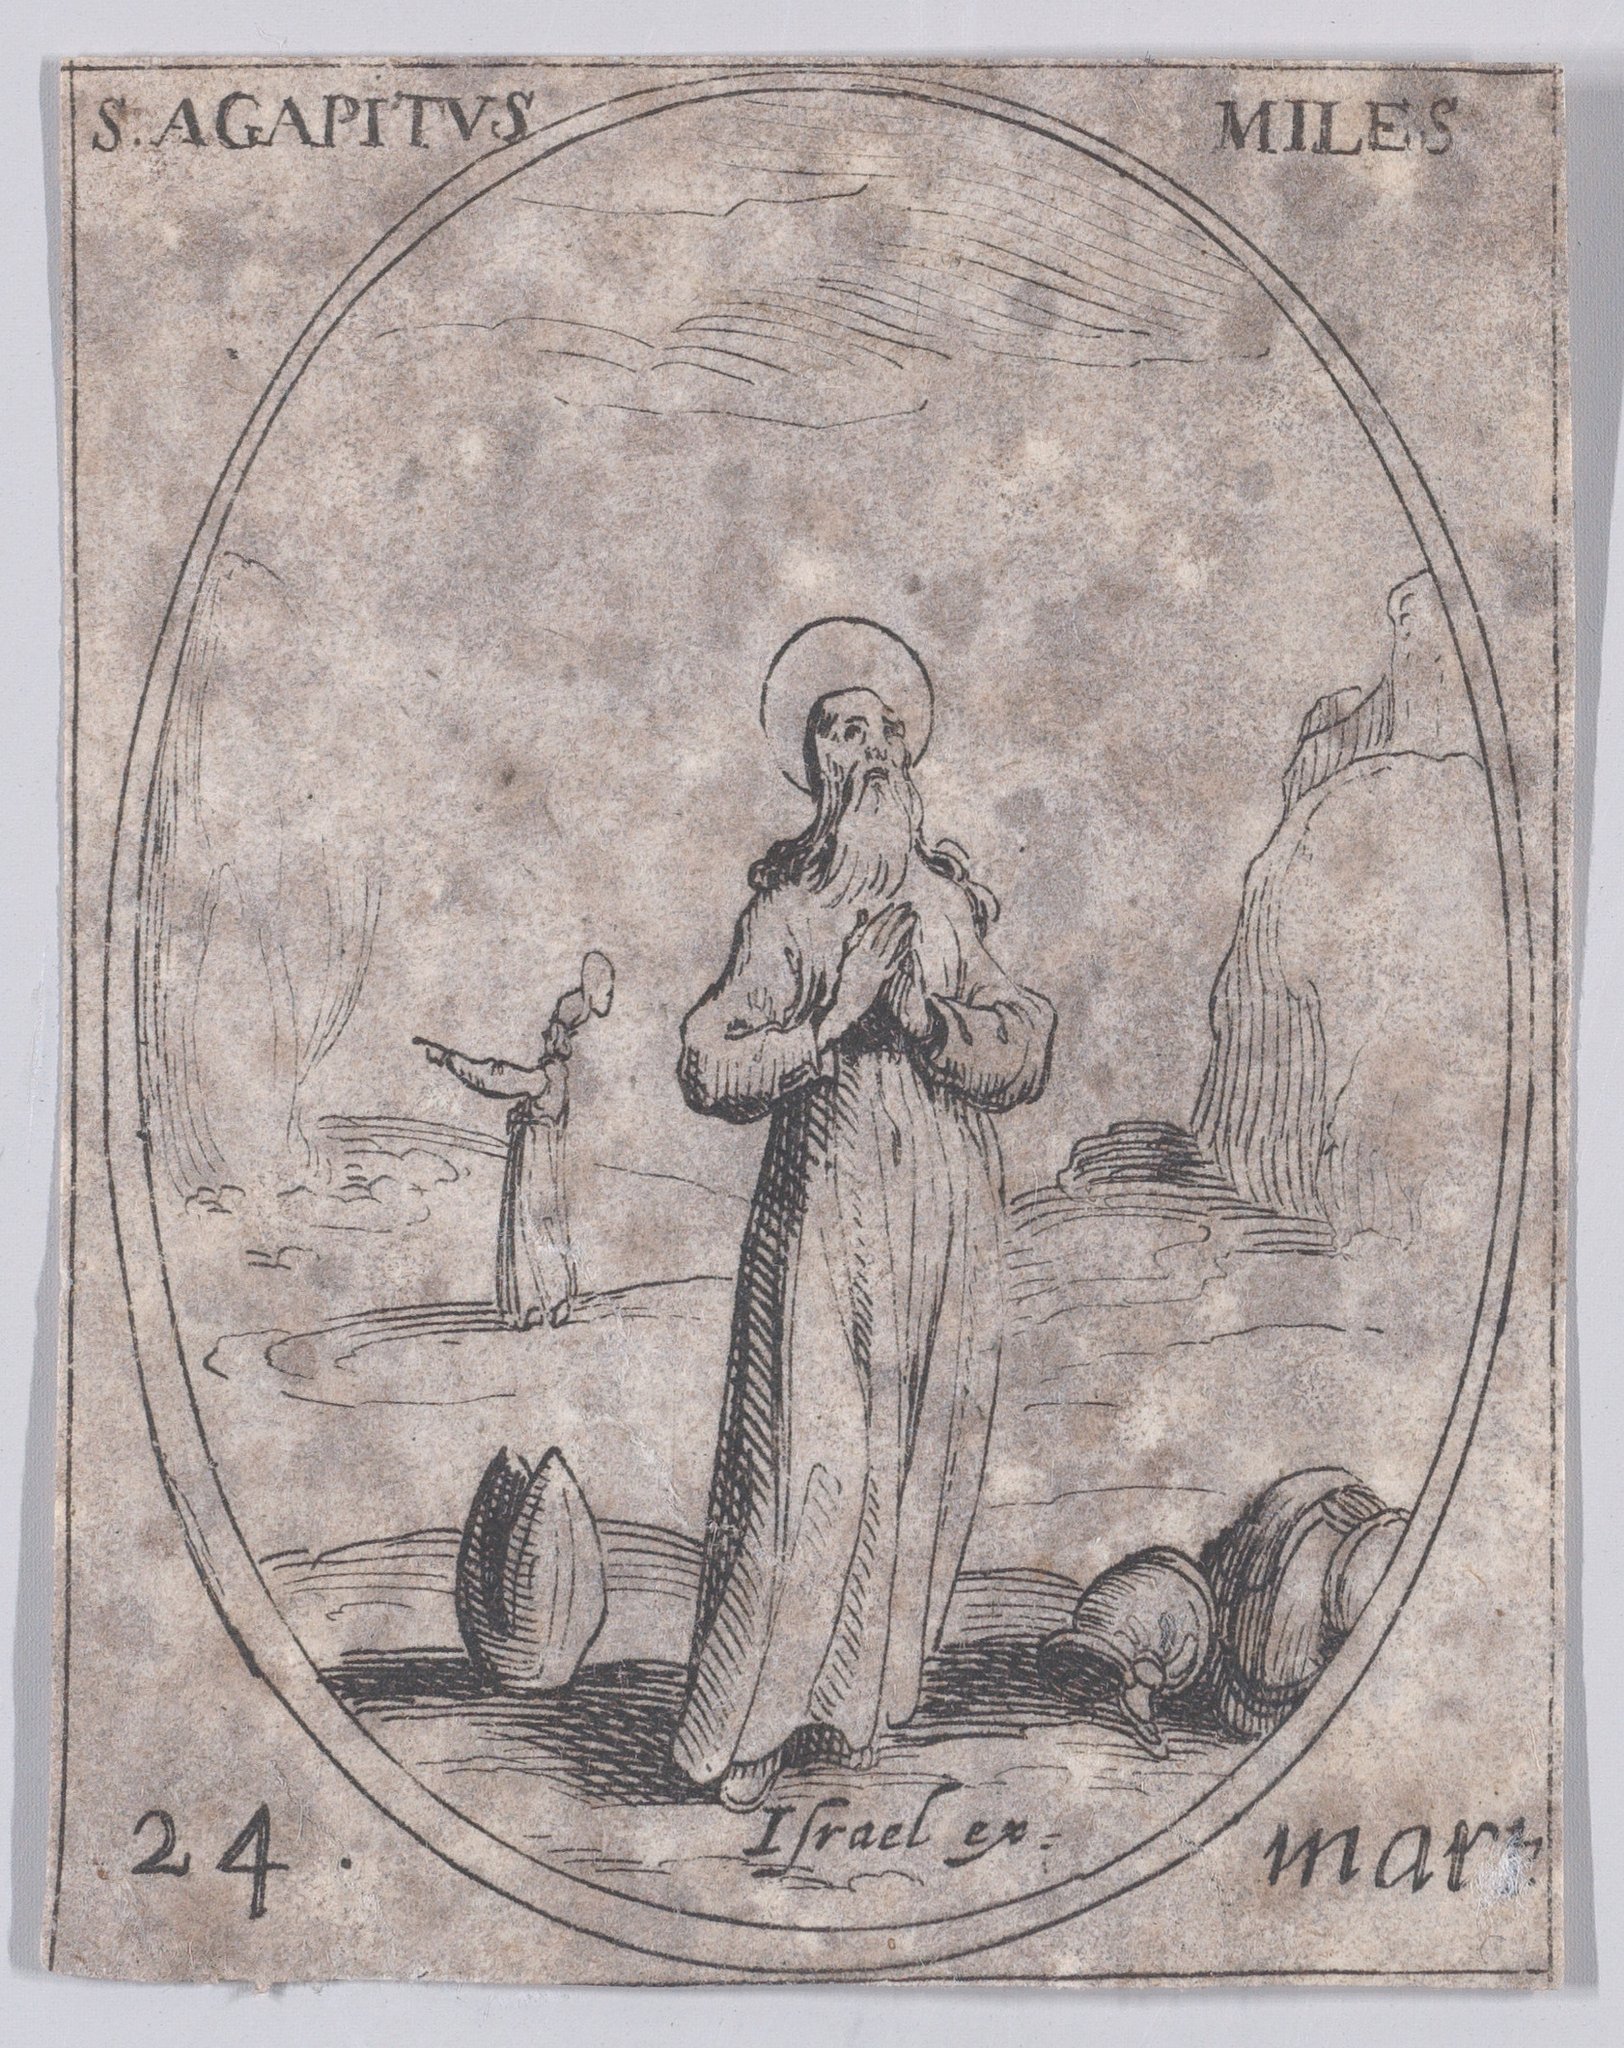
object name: print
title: S. Agapit, soldat (St. Agapitus, Soldier), March 24th, from "Les Images De Tous Les Saincts et Saintes de L'Année" (Images of All of the Saints and Religious Events of the Year)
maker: jacques callot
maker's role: artist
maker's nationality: french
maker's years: 1592-1635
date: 1636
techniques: etching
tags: men,saints